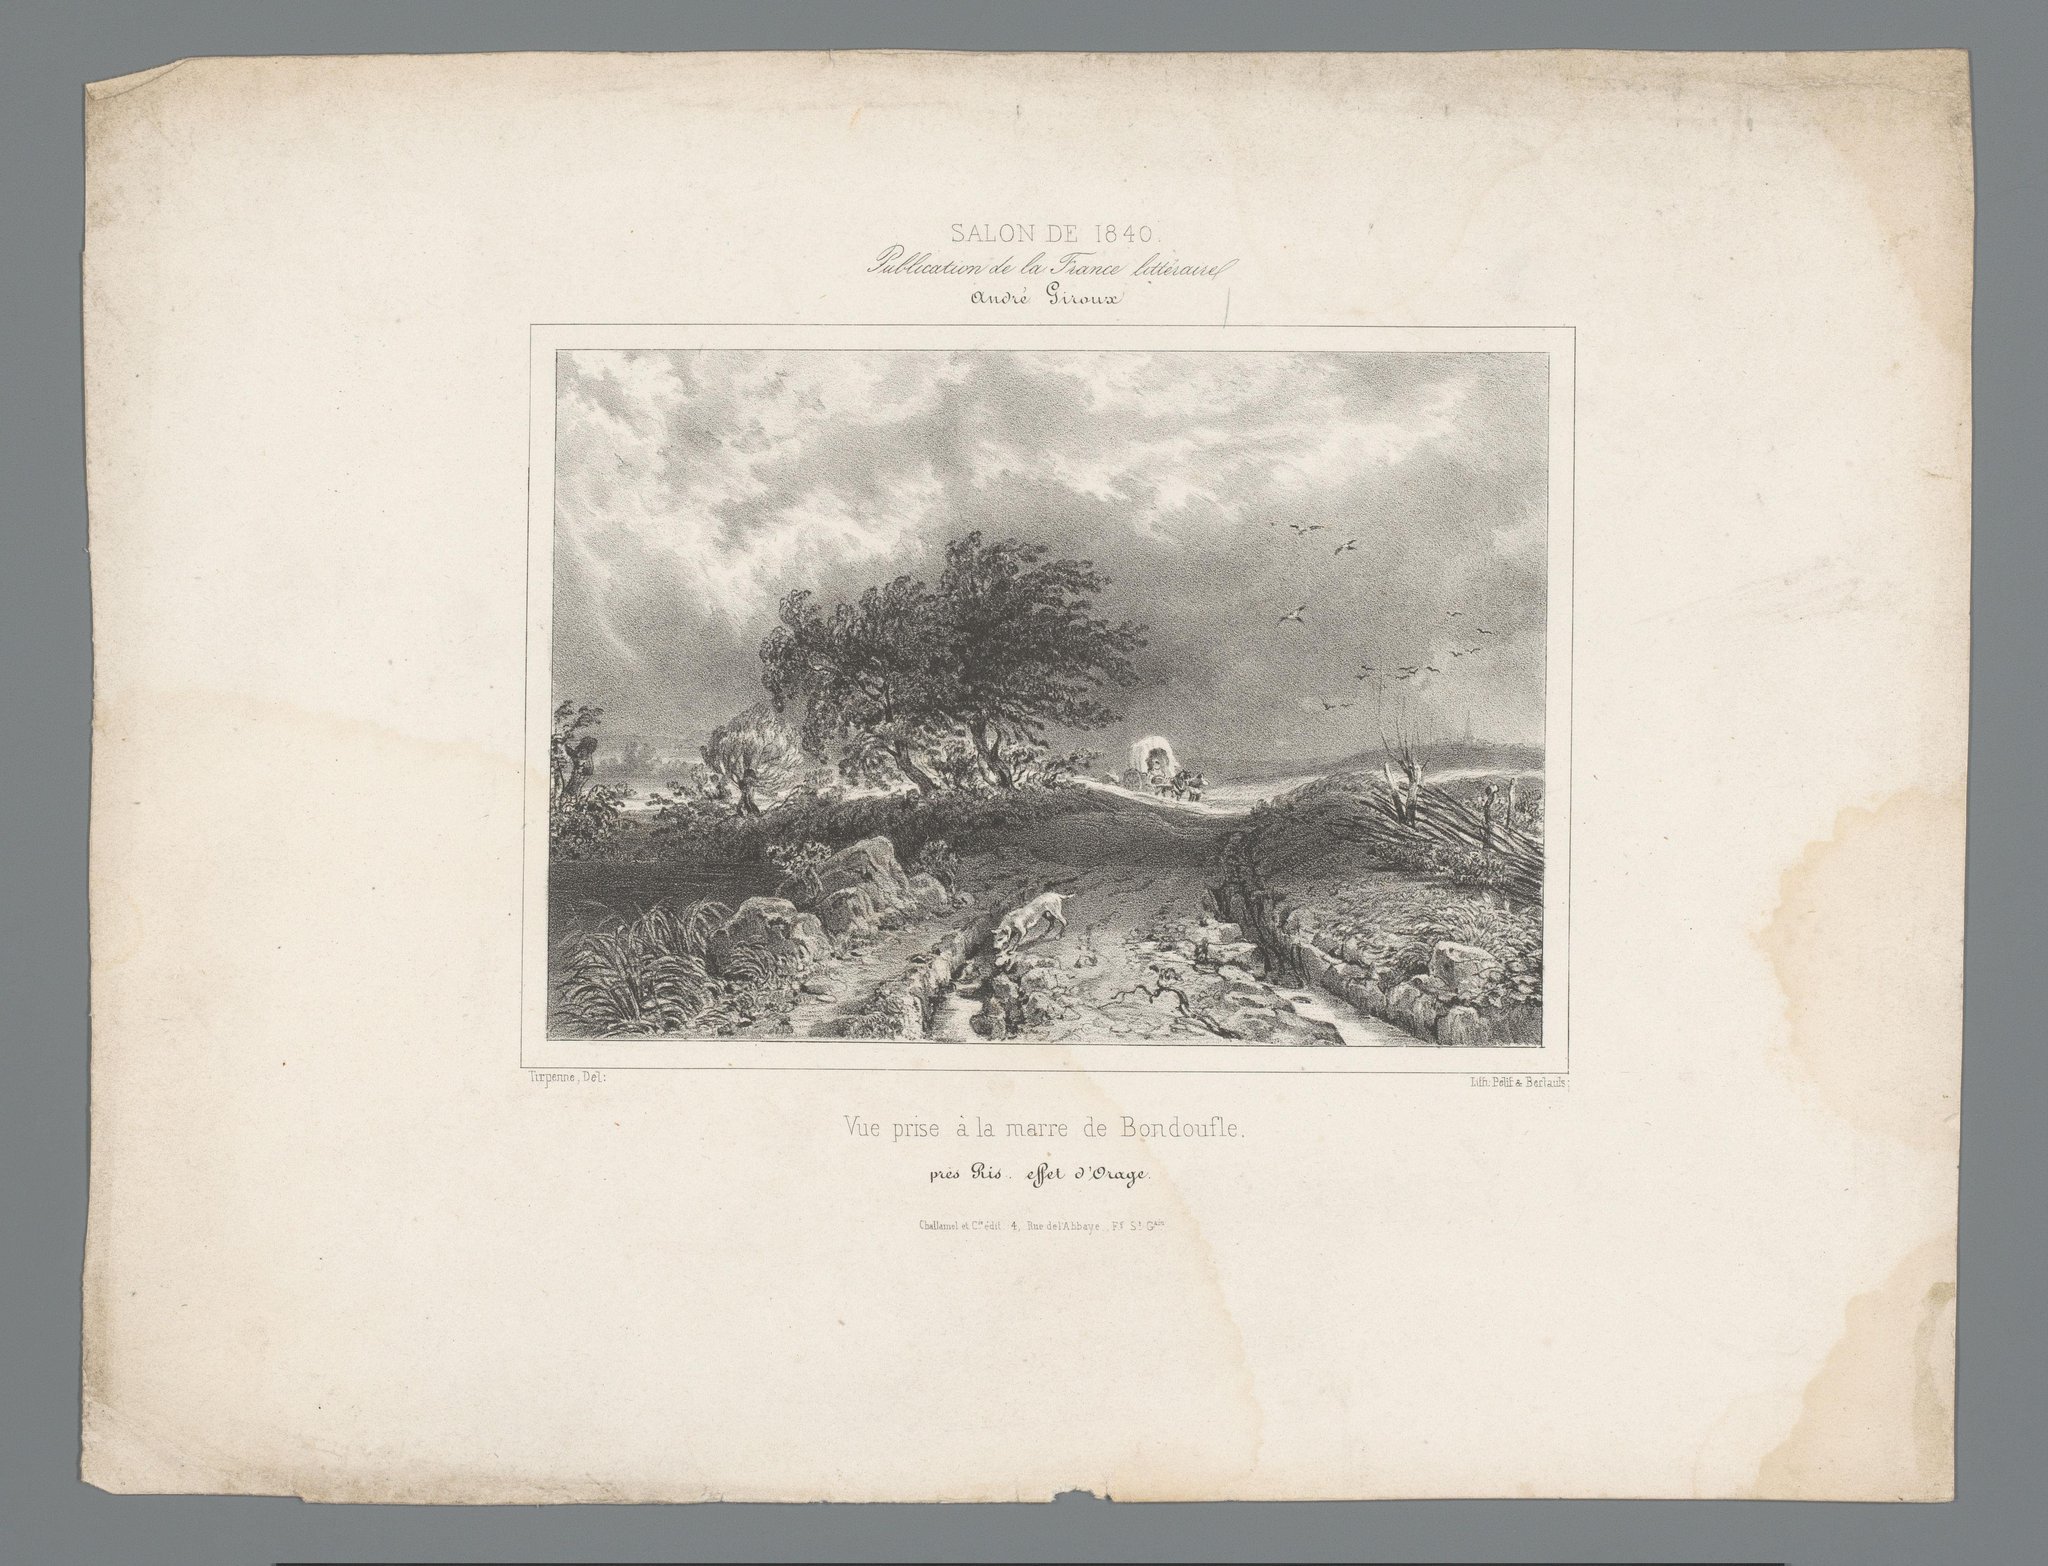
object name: print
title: Landweg bij Bondoufle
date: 1840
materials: paper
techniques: lithograph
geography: paris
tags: thunderstorm, road, path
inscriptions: collector's mark: Lugt 2228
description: Prent uit: Robert, Jules. Album du Salon de 1840. Collection des principaux ouvrages exposés au Louvre (…). Parijs: Challamel & Cie, 1840.